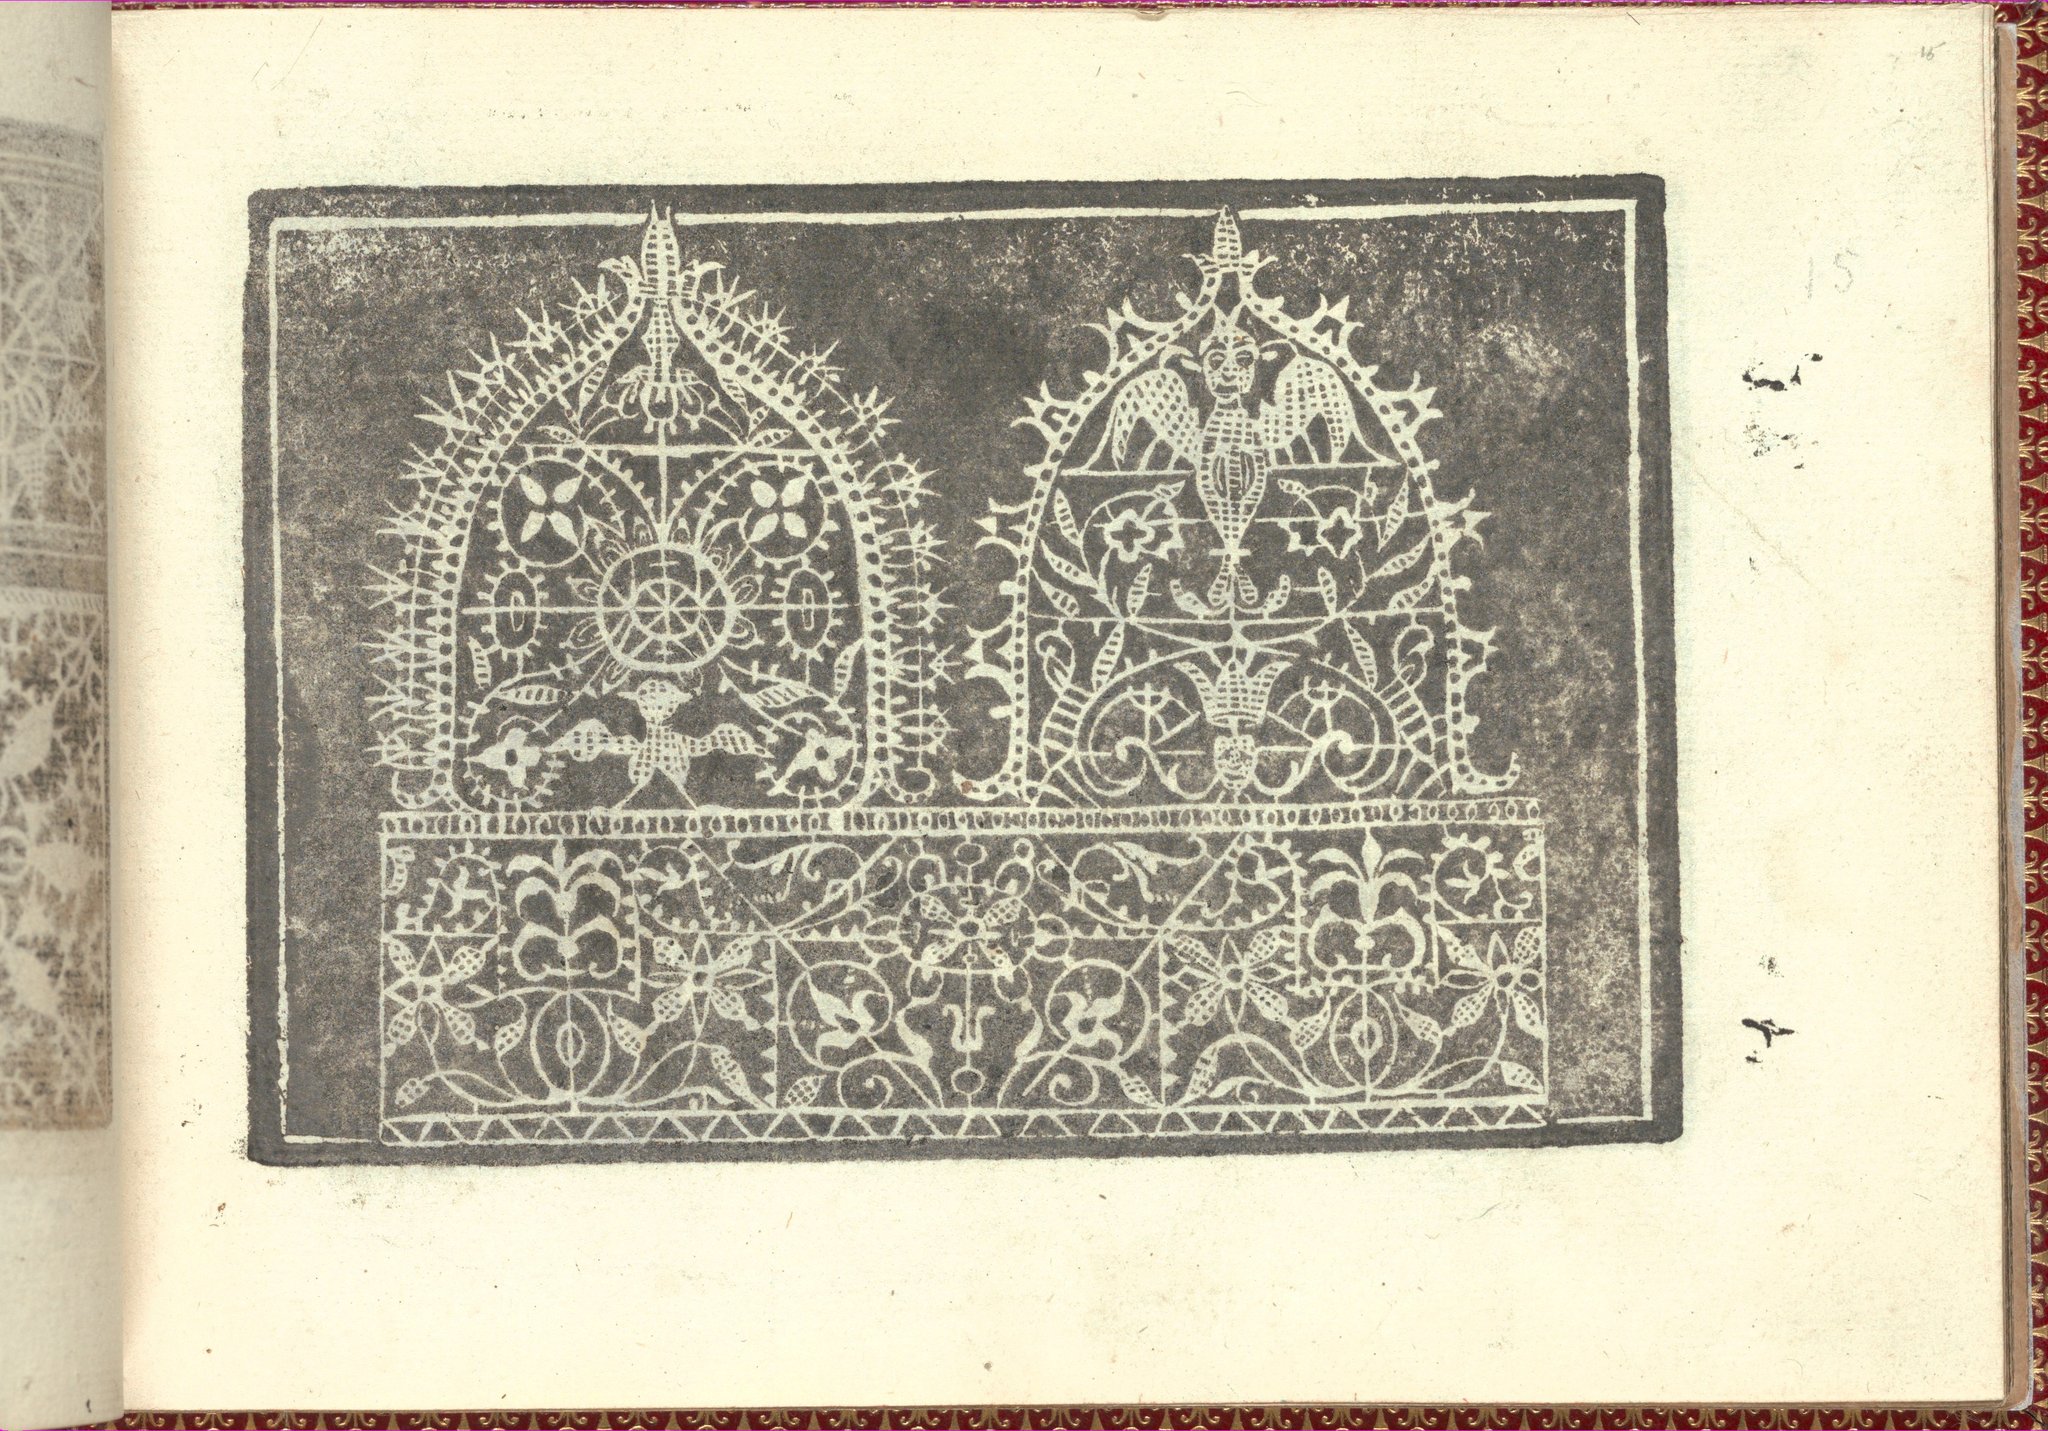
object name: book print ornament architecture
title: Corona delle Nobili et Virtuose Donne: Libro I-IV, page 15 (recto)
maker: cesare vecellio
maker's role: publisher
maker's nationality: italian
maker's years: 1521-1601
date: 1601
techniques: woodcut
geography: italy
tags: flowers,vines